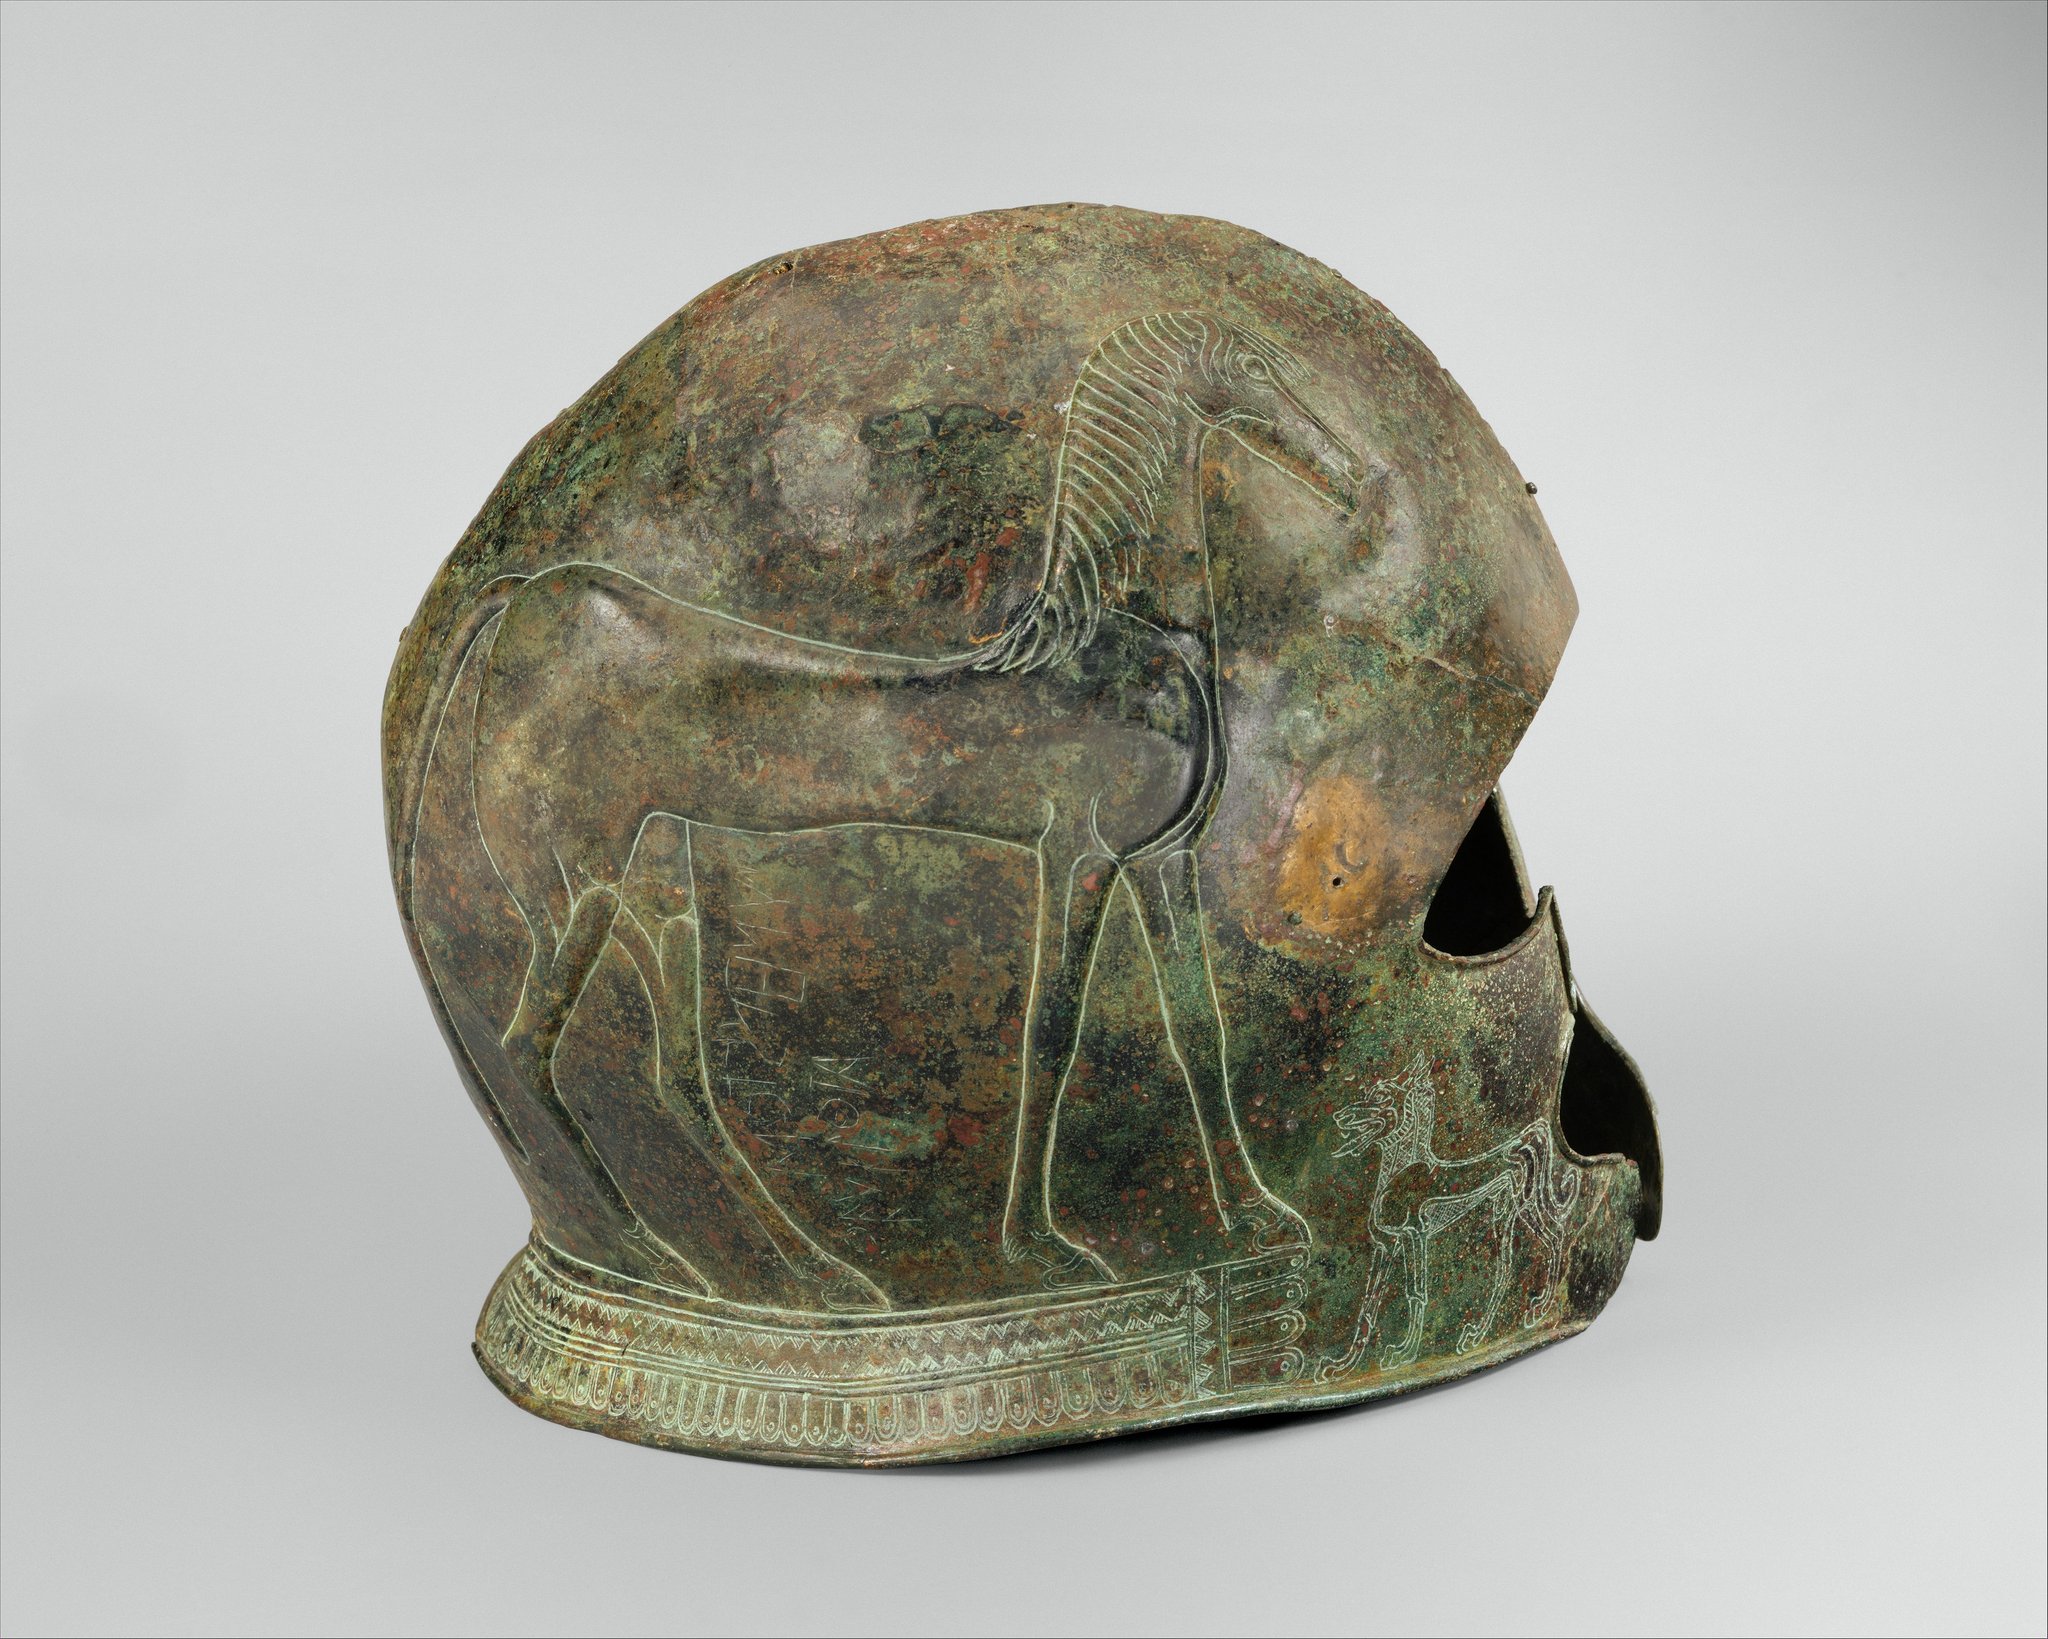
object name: helmet with horse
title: Bronze helmet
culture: greek, cretan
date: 634-601 BCE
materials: bronze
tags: horses,lions